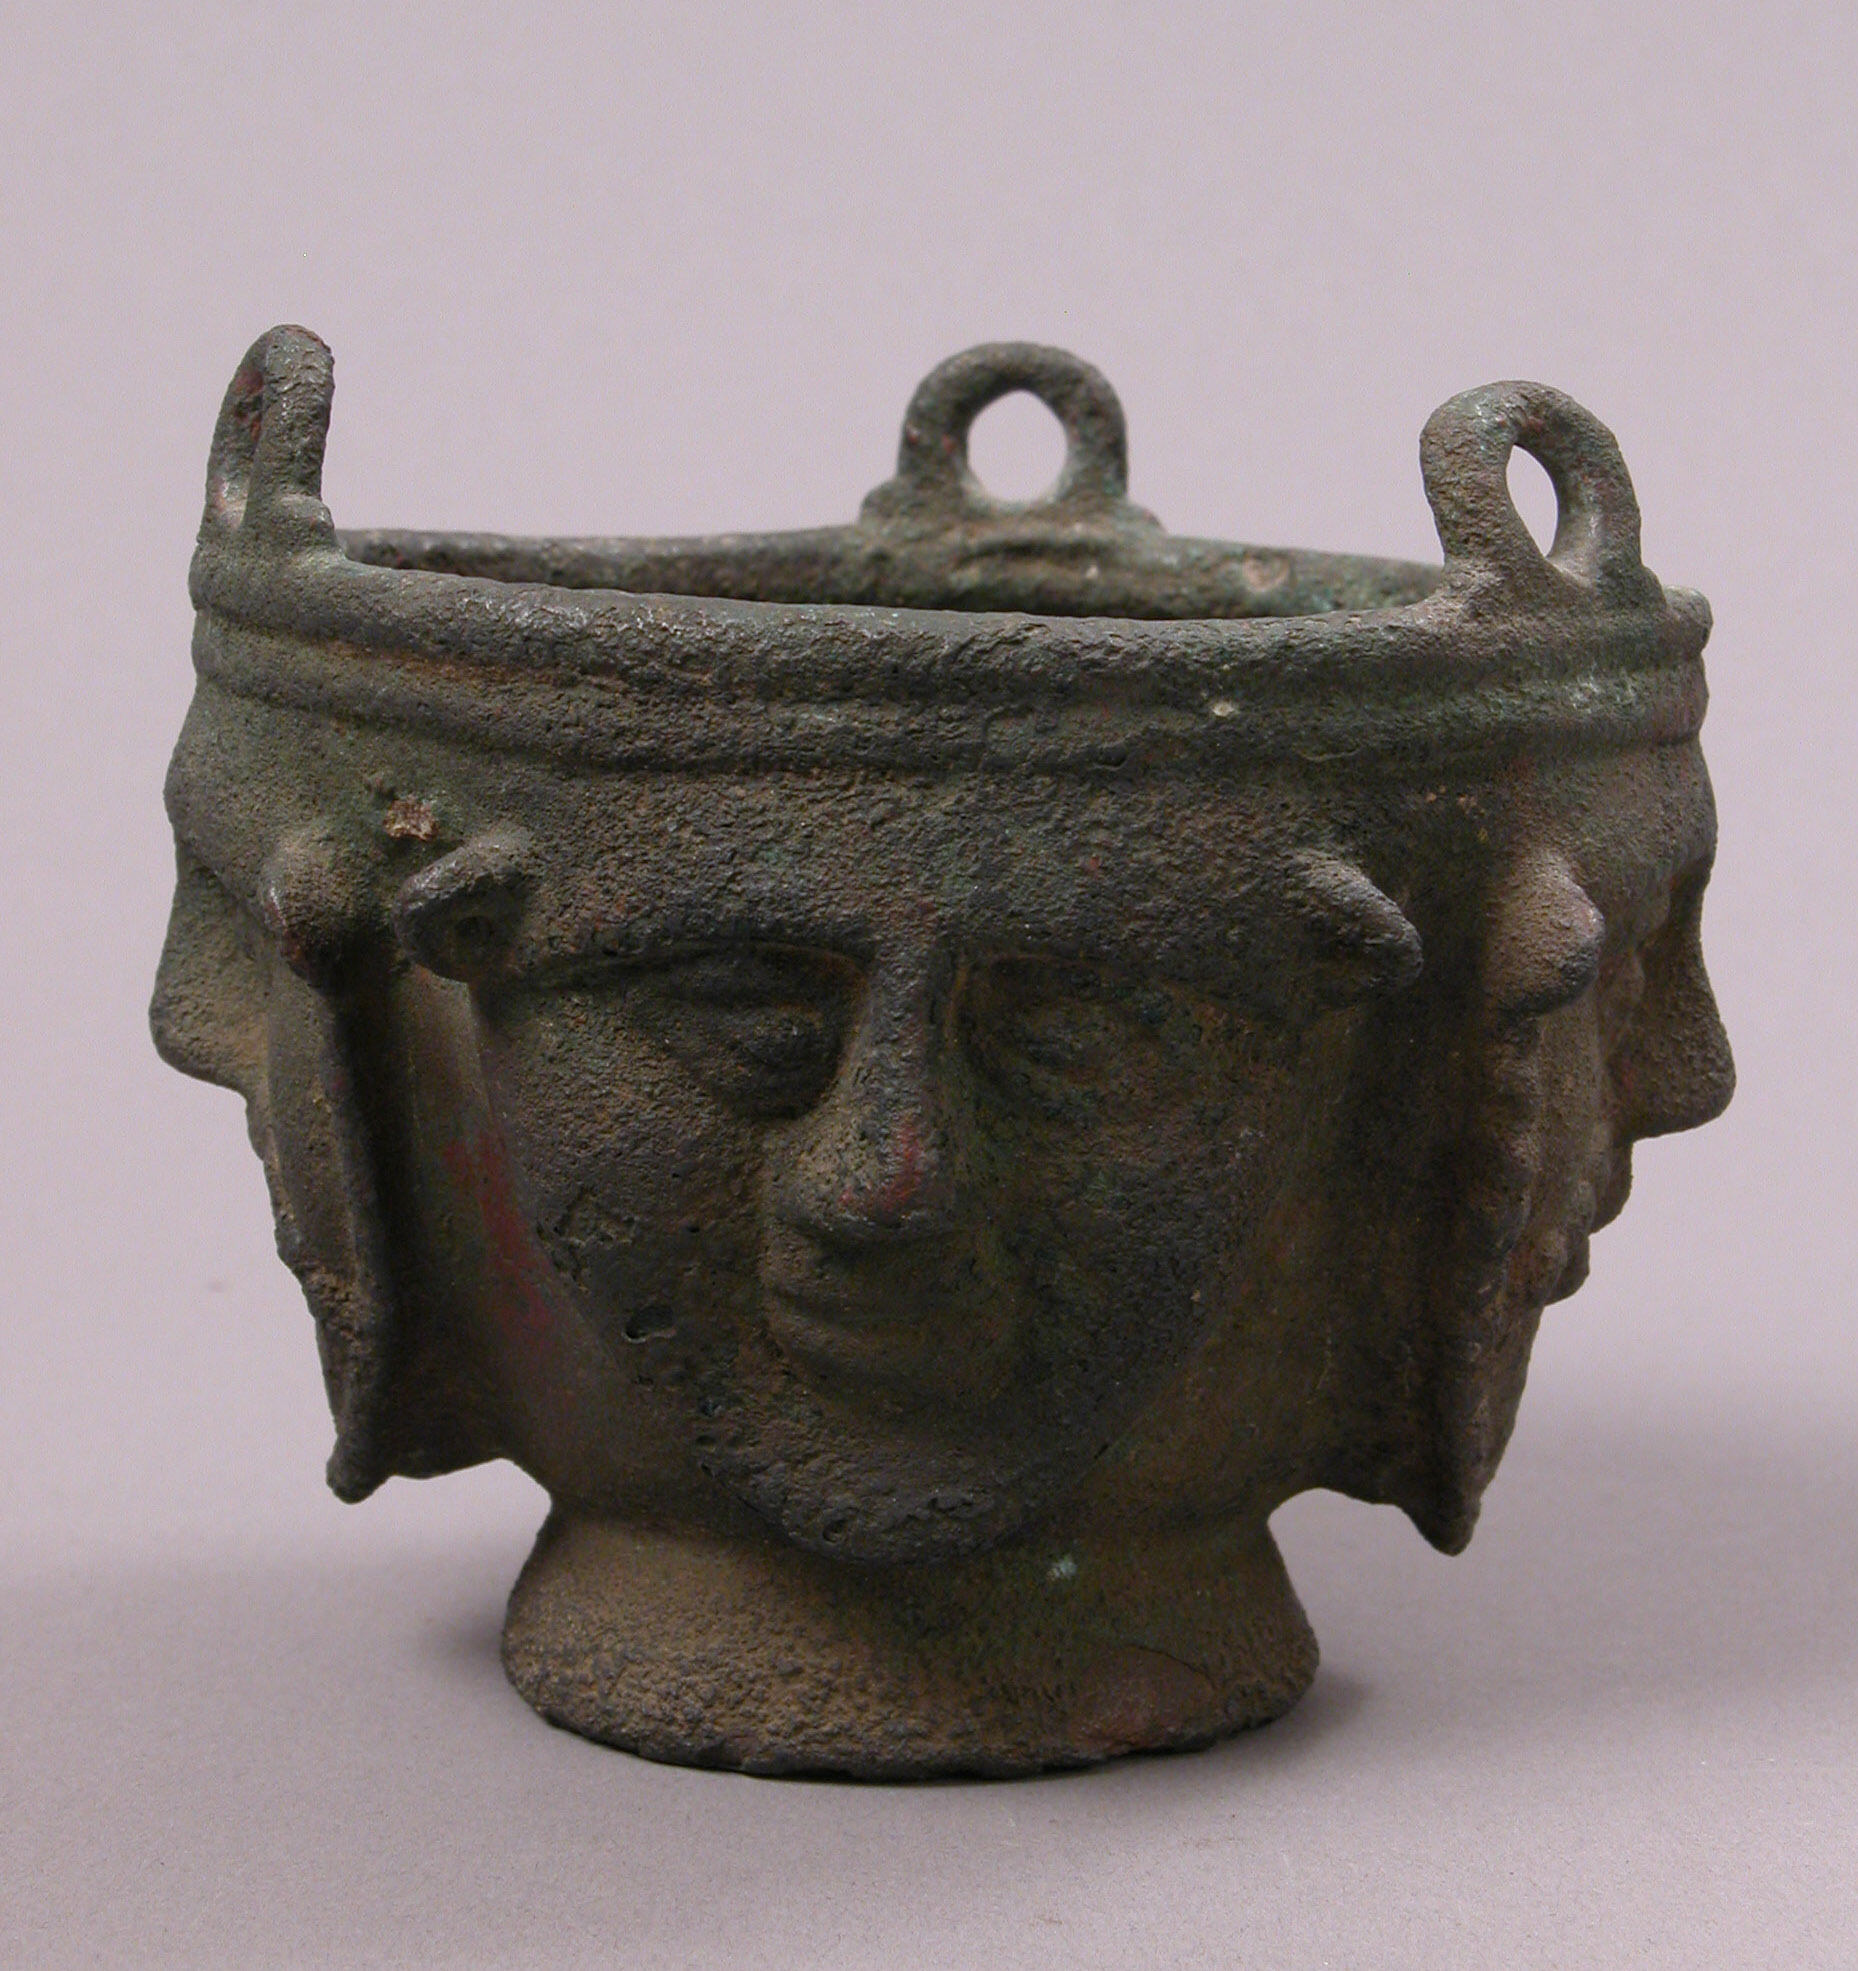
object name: censer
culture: italian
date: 1001-1400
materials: copper alloy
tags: faces